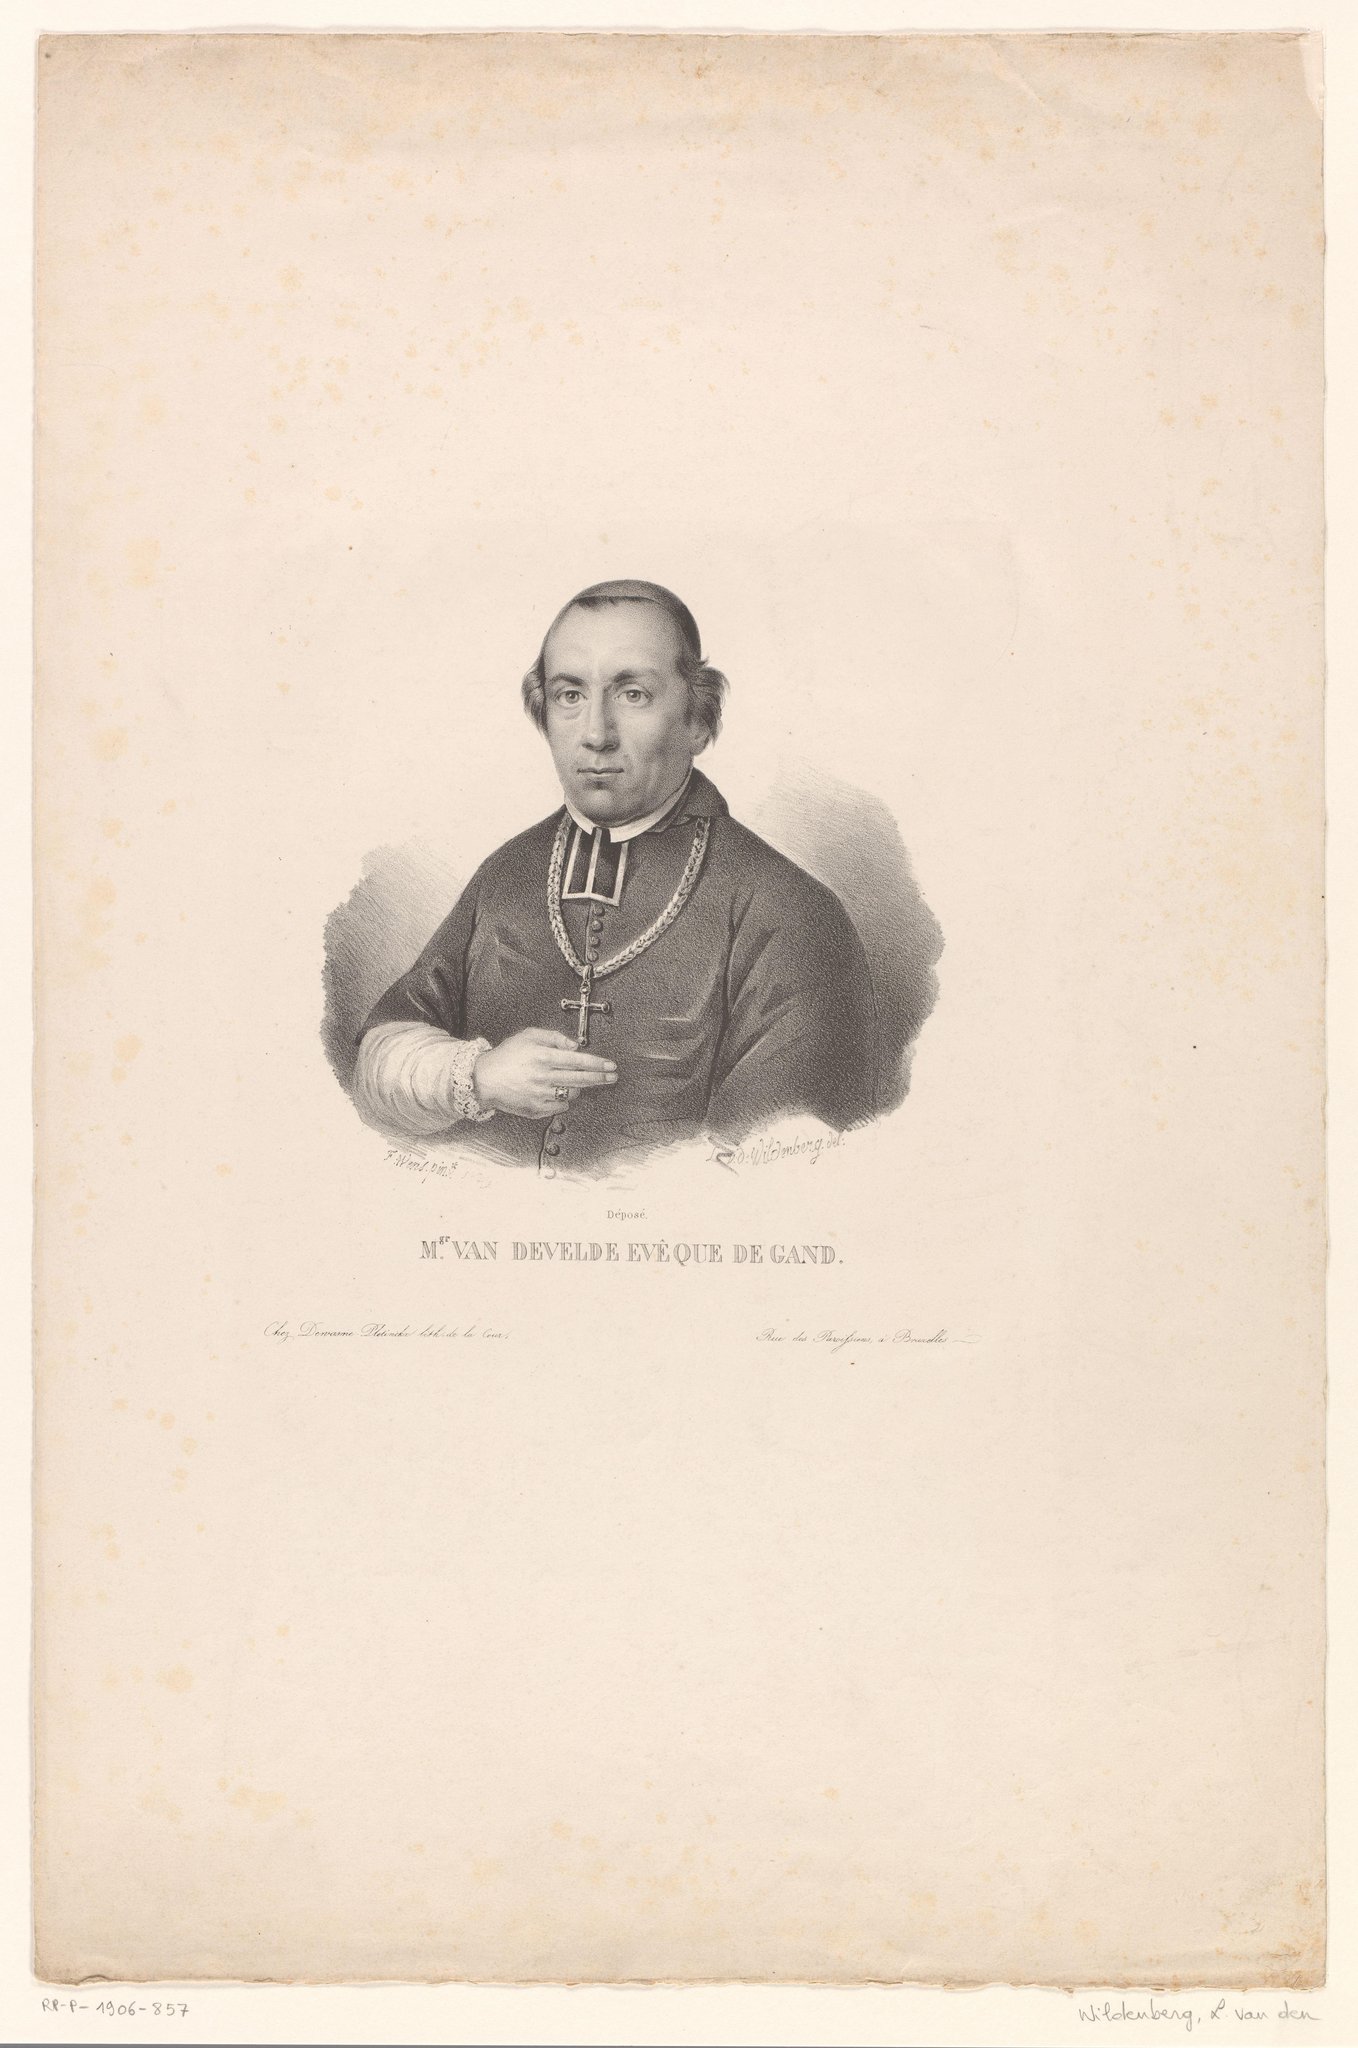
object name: print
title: M.gr van Develde evêque de Gand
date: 1829-1836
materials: paper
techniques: lithograph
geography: brussels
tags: boom, ghent, archbishop, bishop, etc. (roman catholic), historical persons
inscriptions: : ‘Déposé’, collector's mark: Lugt 2228